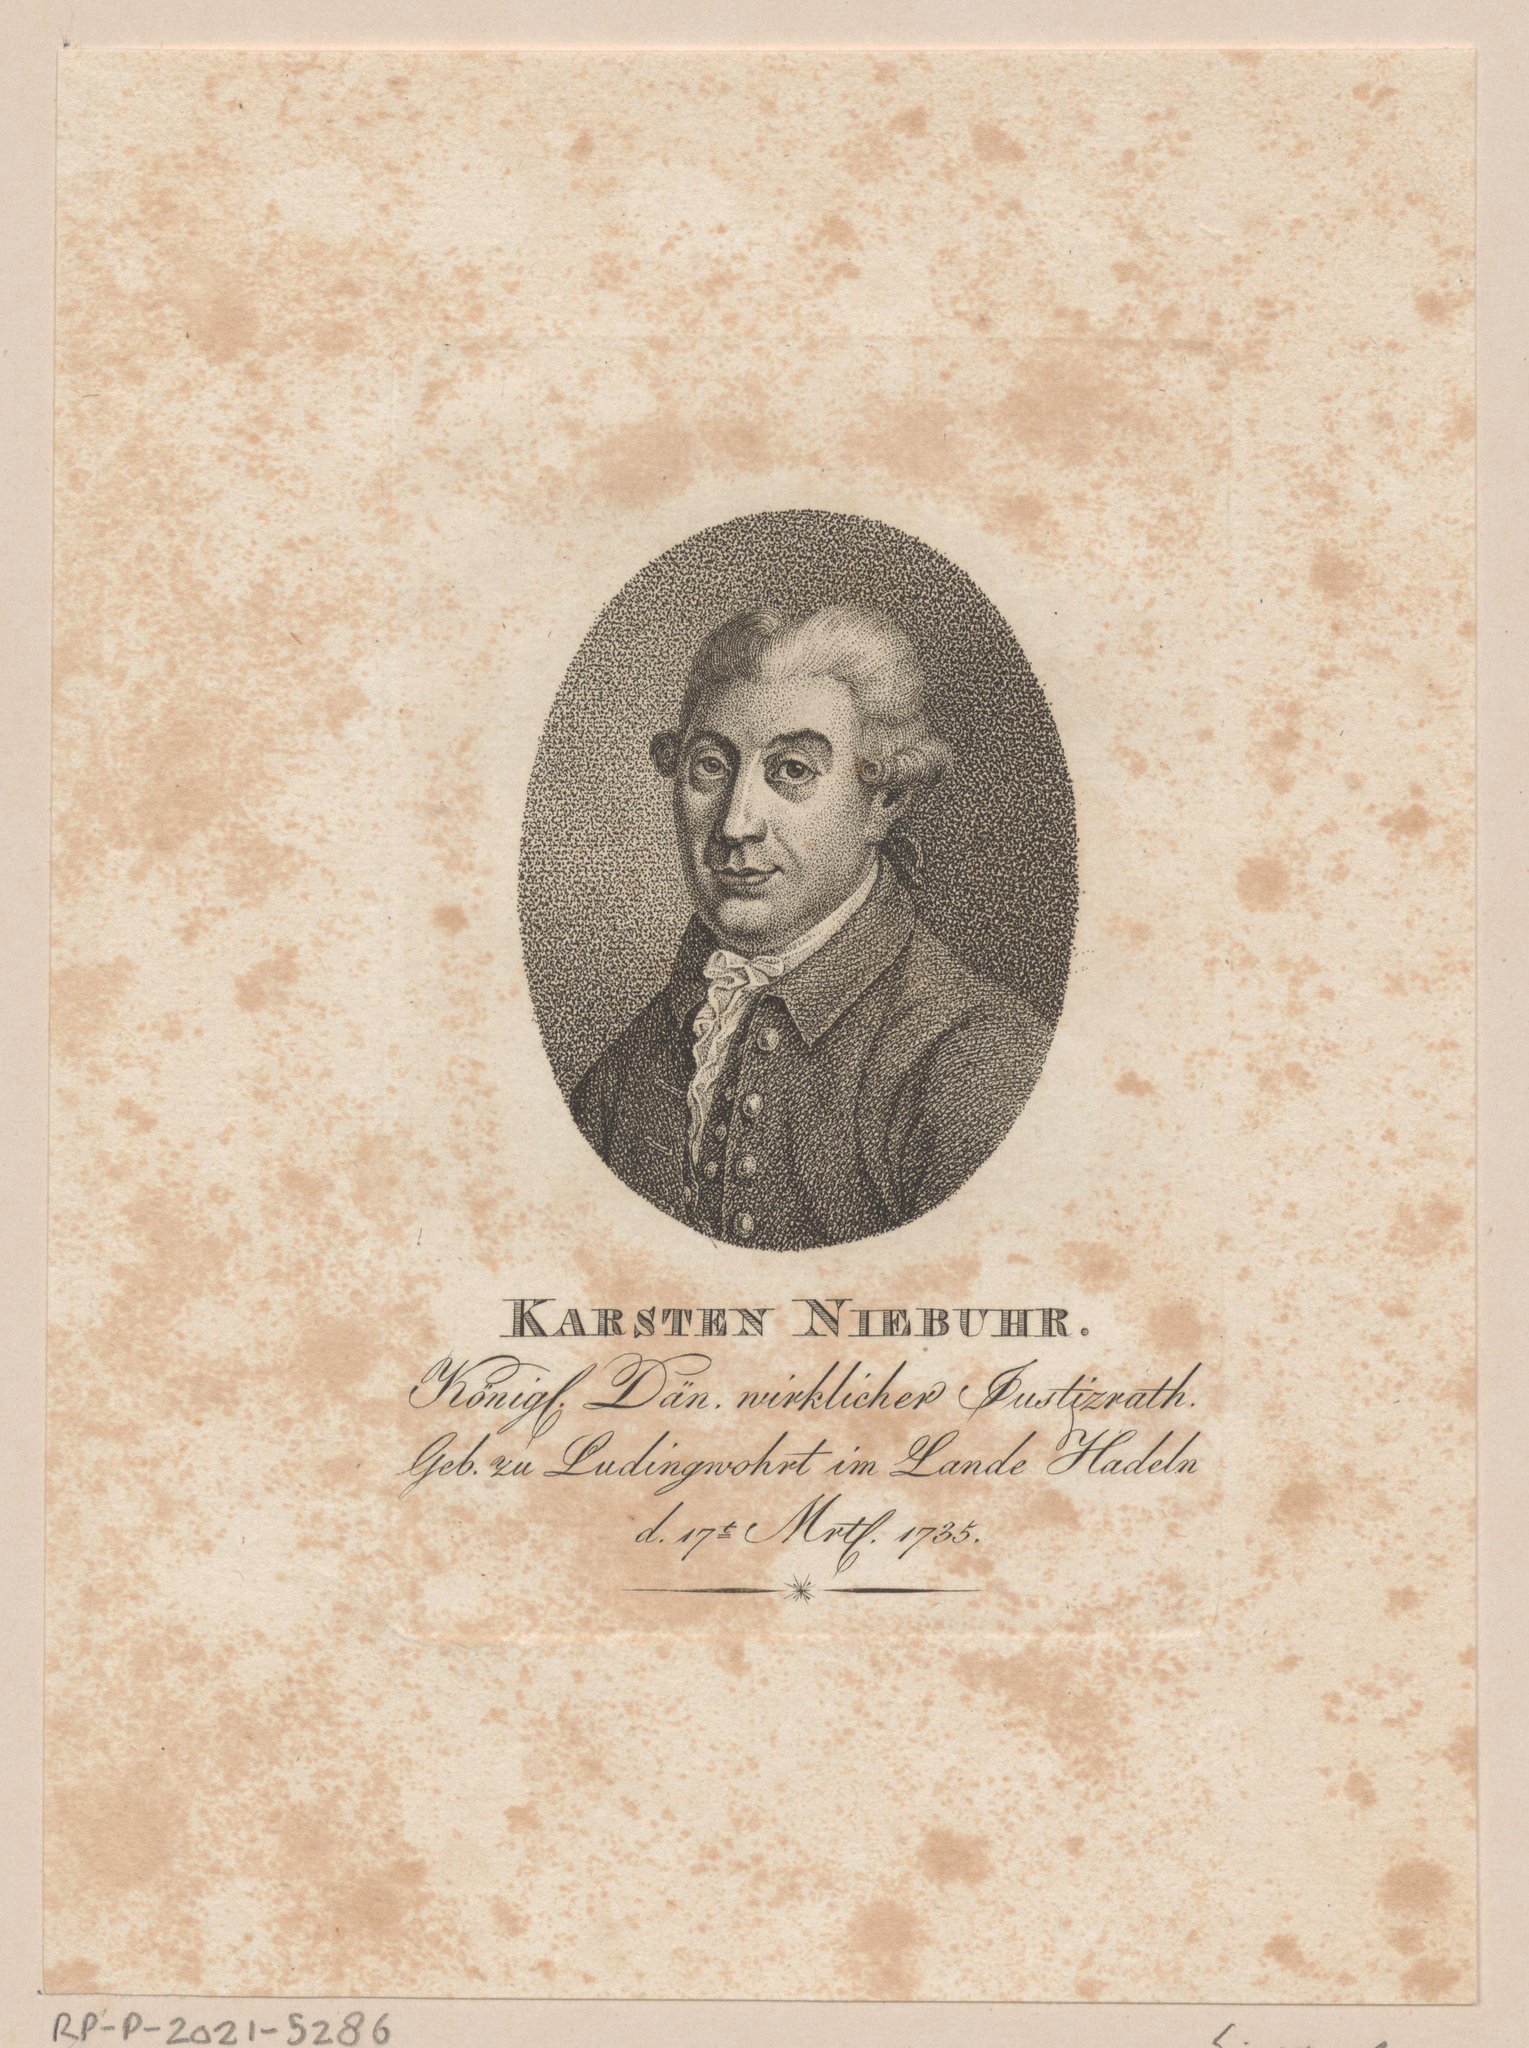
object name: print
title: Portret van Carsten Niebuhr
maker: Anonymous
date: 1810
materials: paper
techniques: engraving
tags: historical persons, portrait of a writer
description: Prent mogelijk uit: Allgemeine geographische Ephemeriden. Weimar: Landes-Industrie-Comptoirs, 1810, dl. 31